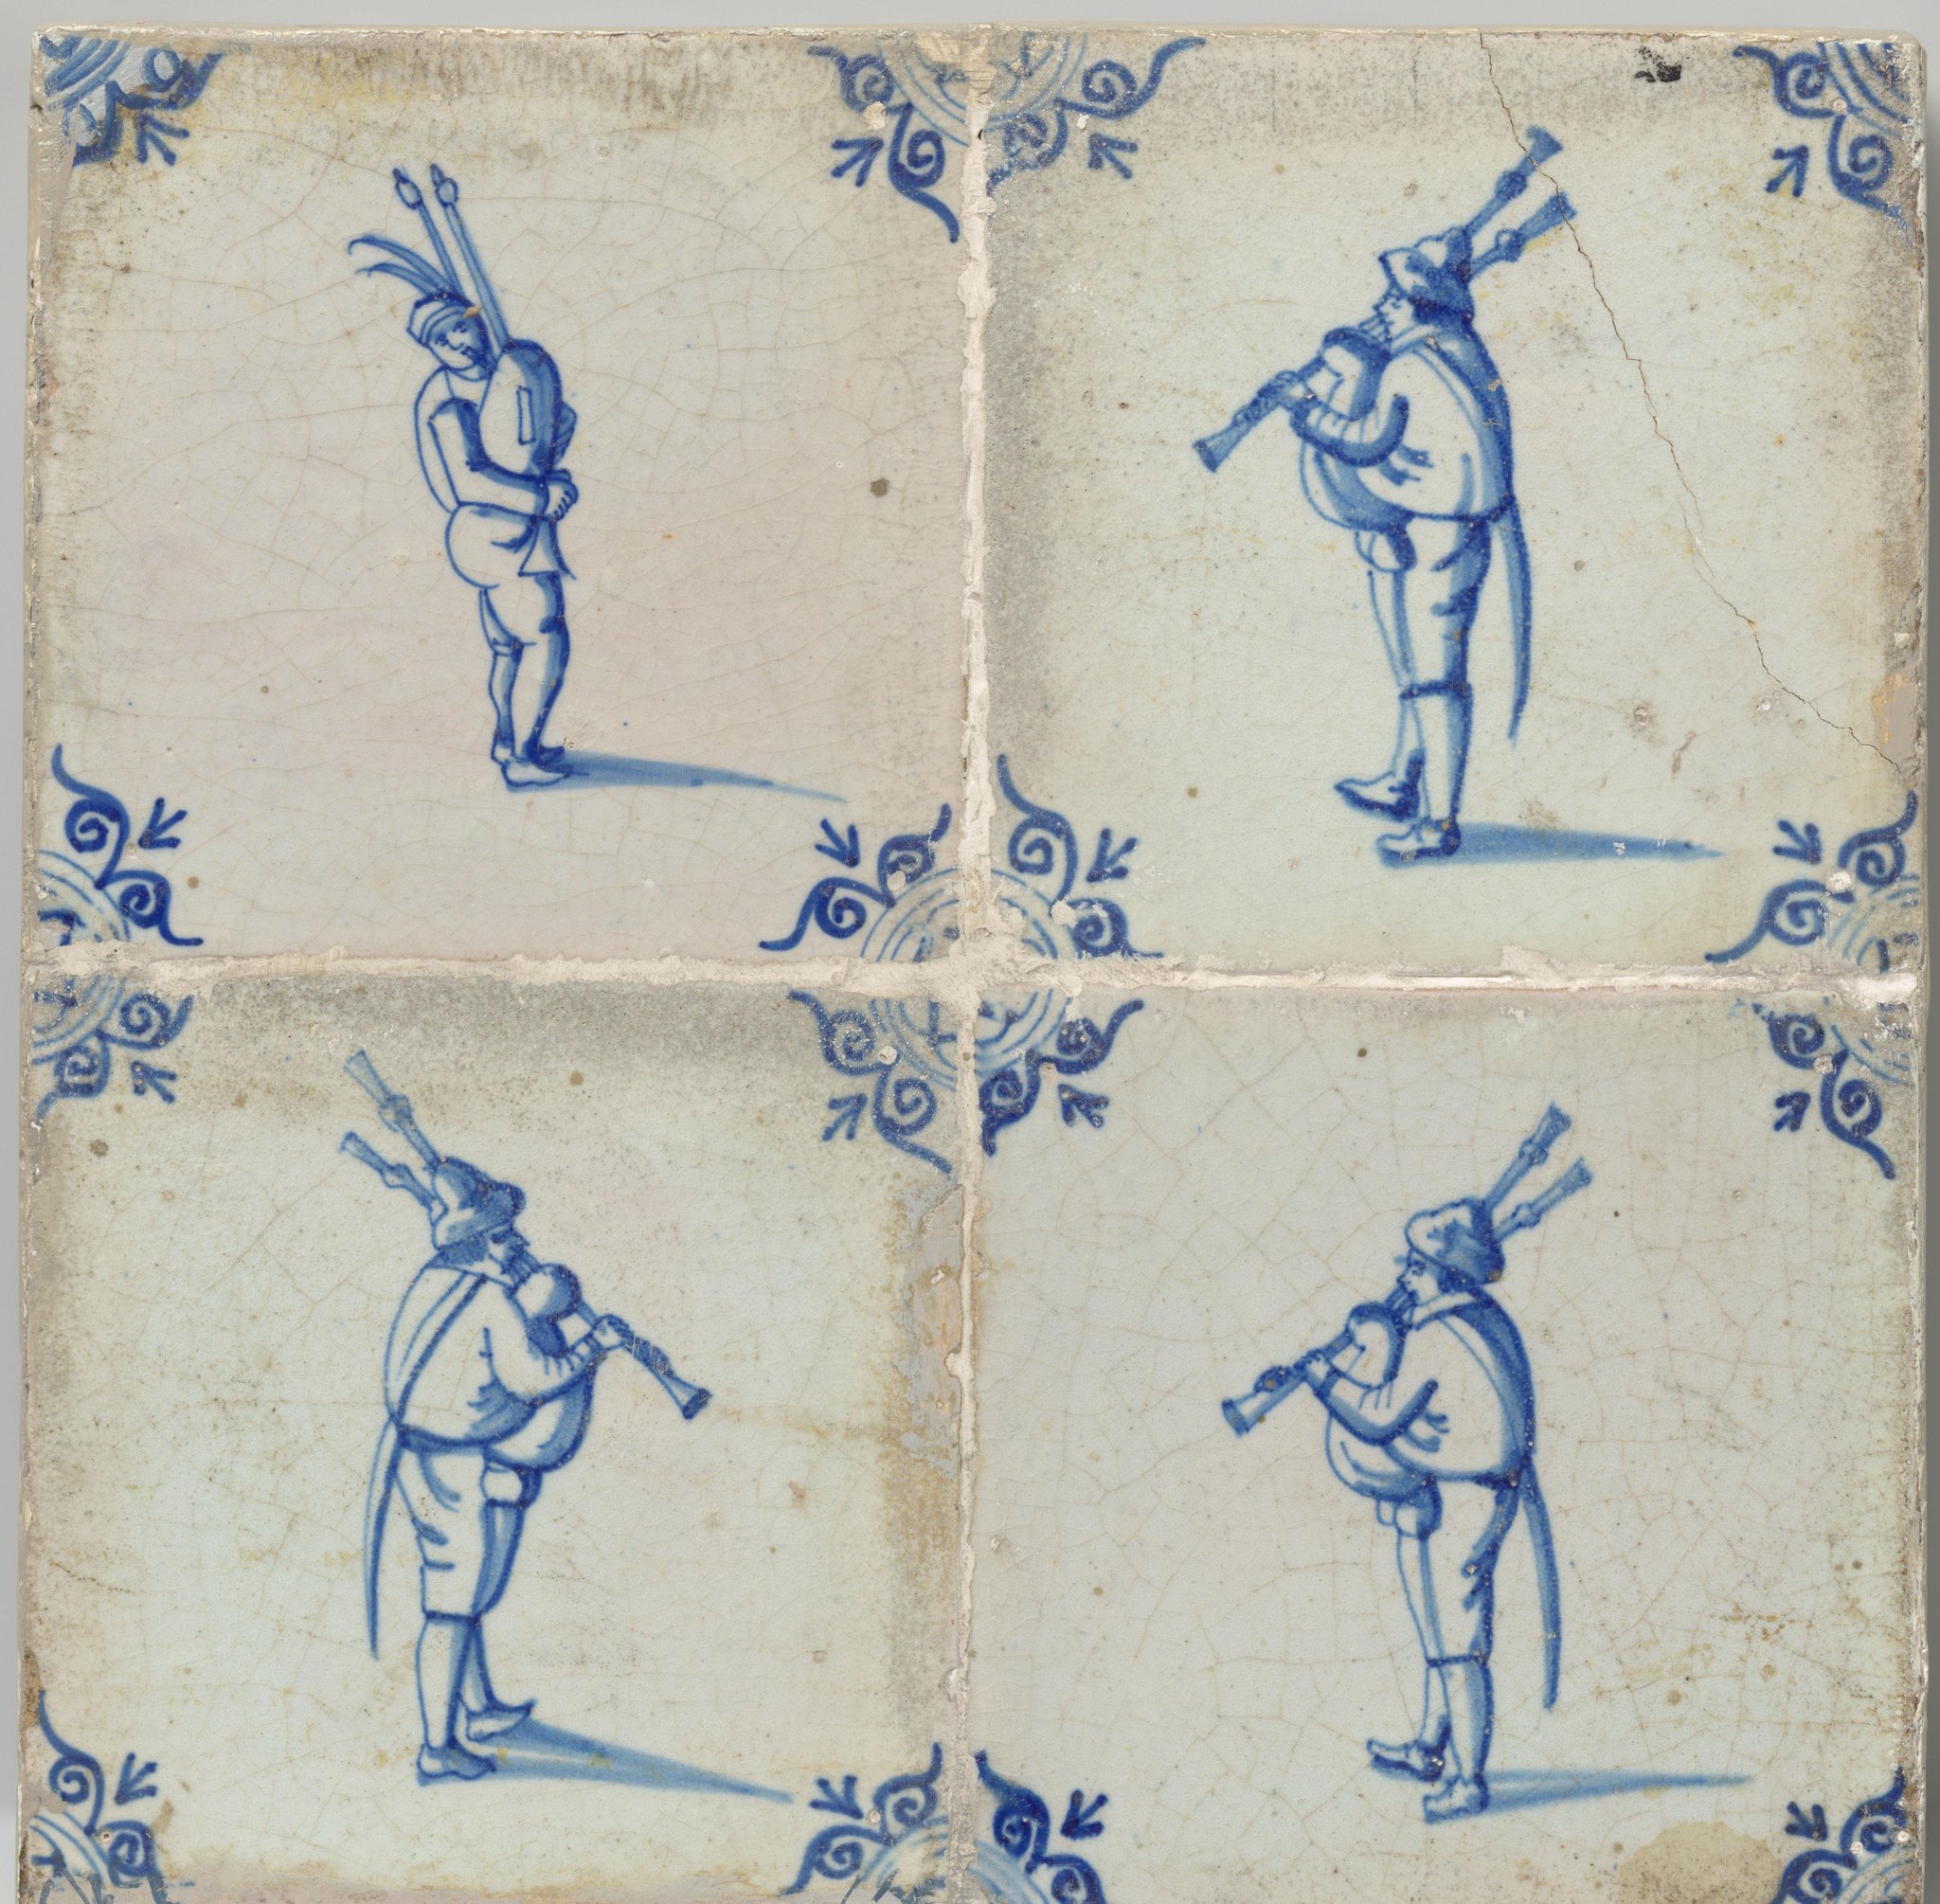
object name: tile tableau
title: Tegeltableau van vier tegels met op doedelzak spelende figuur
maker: Anonymous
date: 1625-1650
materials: earthenware, glaze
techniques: maiolica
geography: netherlands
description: Veld van vier tegels (2 x 2) elk met een paars geschilderde figuur spelend op een doedelzak. In de hoeken, een ossenkop.